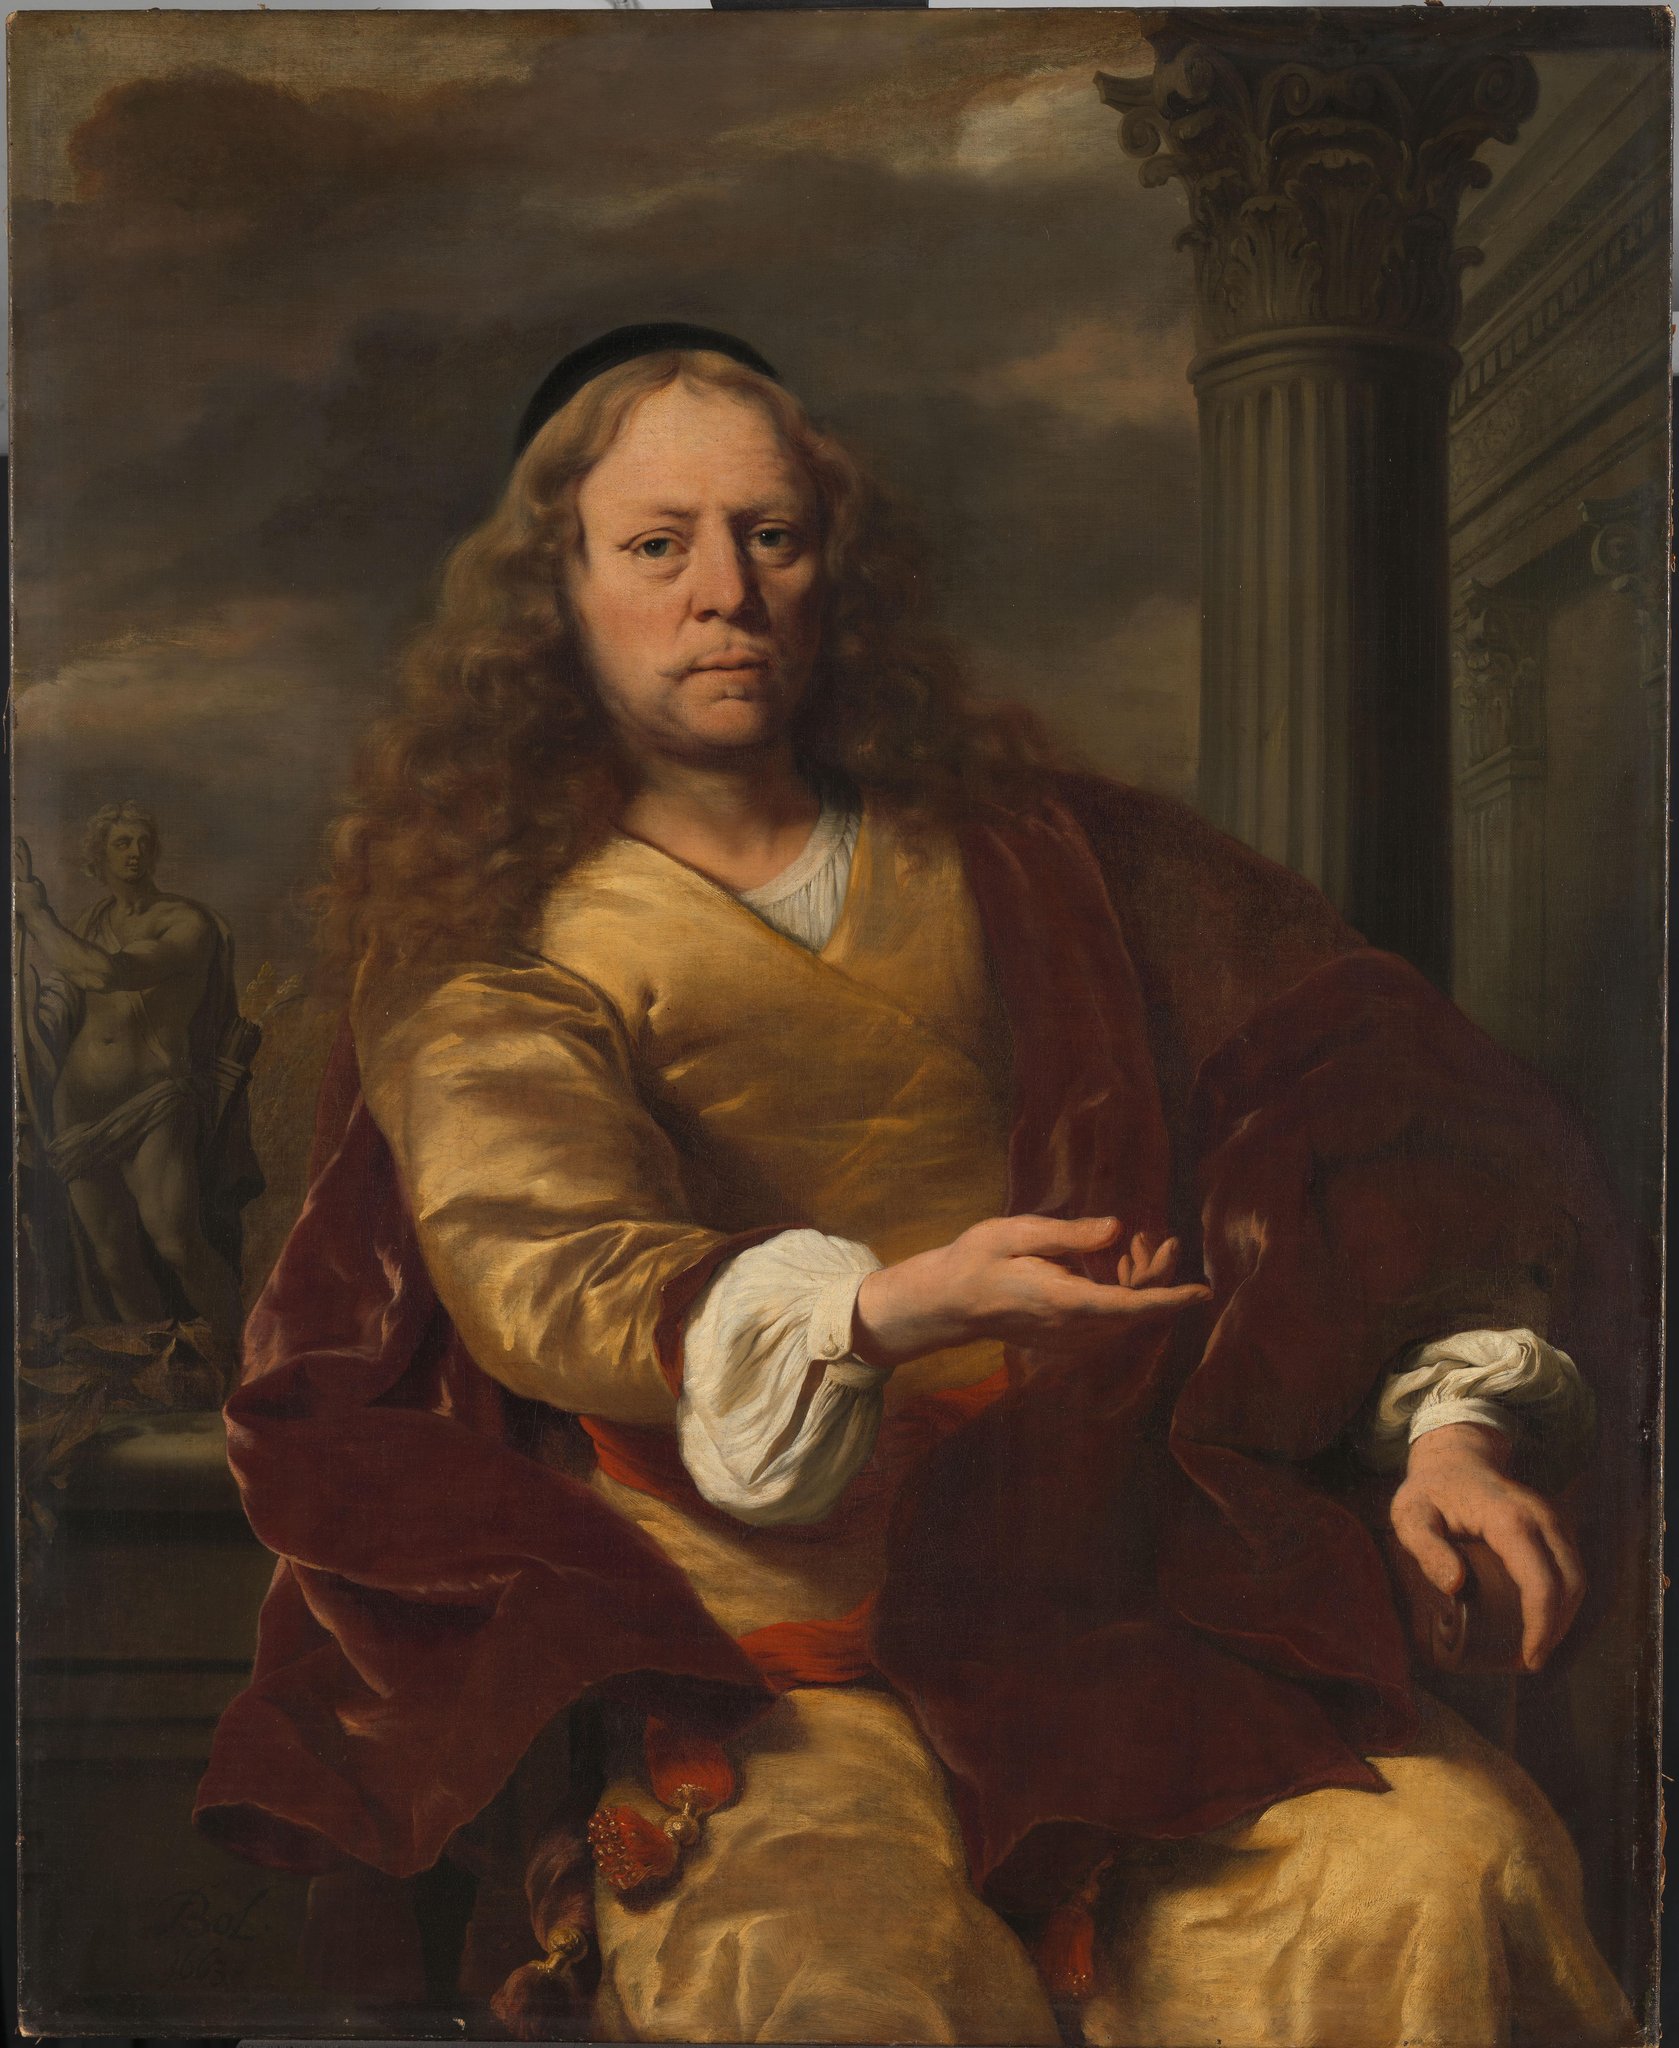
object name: painting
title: Portrait of a Man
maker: ferdinand bol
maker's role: draughtsman, painter, print maker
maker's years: 1616-1680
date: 1663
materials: canvas, oil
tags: historical persons not known by name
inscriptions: signature and date: ‘FBol. 1663.’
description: Portret van een man, zittend met uitgestoken rechterhand. Op de achtergrond een zuil en een beeld van Apollo. De identiteit van de zitter is onbekend; voorgestelde namen zijn: Jacob van Campen, Artus Quellinus en Louis Trip.